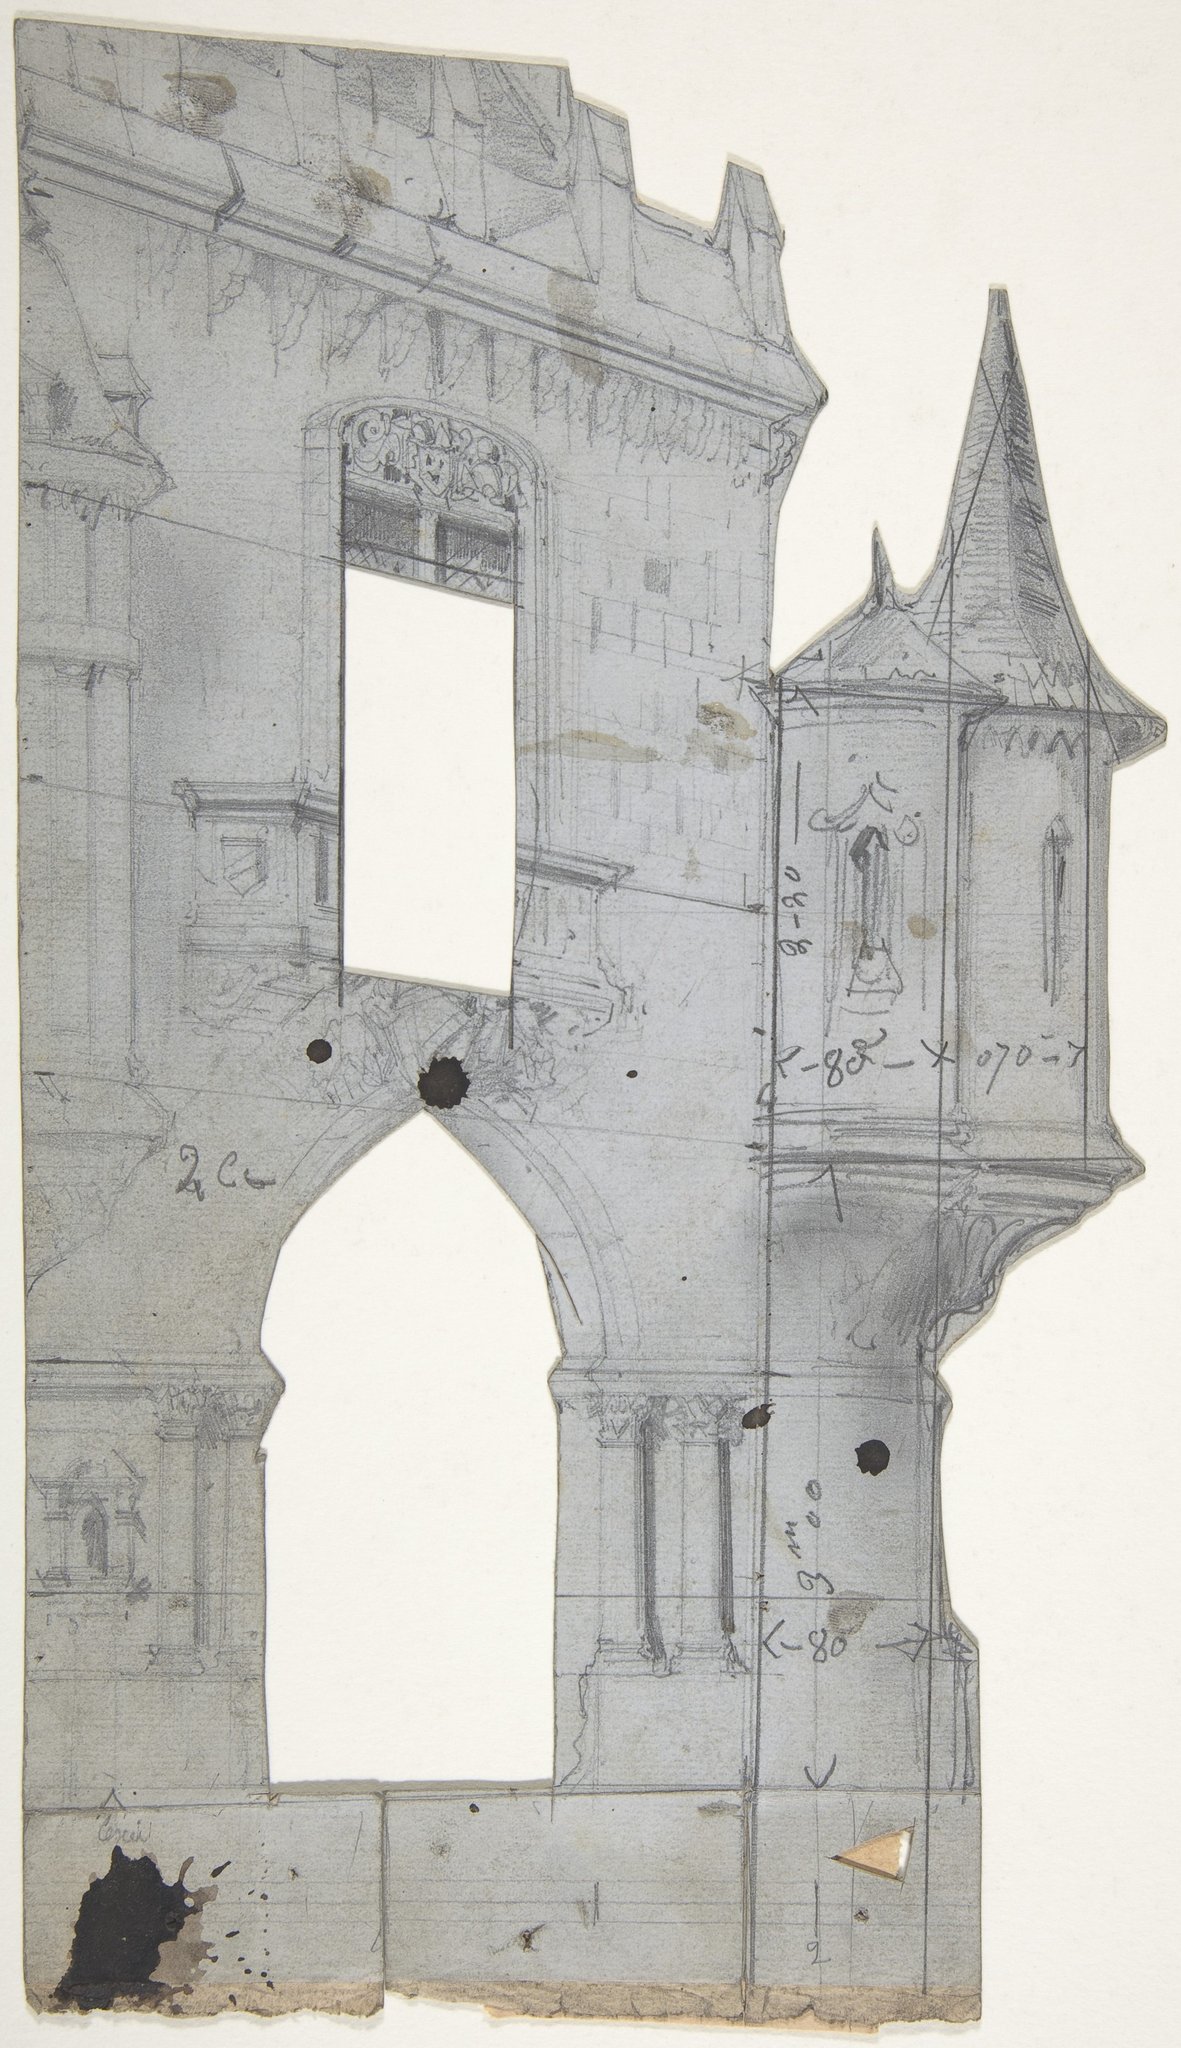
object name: drawing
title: Design for a Stage Set at the Opéra, Paris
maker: eugène cicéri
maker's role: artist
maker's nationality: french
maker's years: 1813-1890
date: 1830-1890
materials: graphite, paper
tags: buildings,stage design